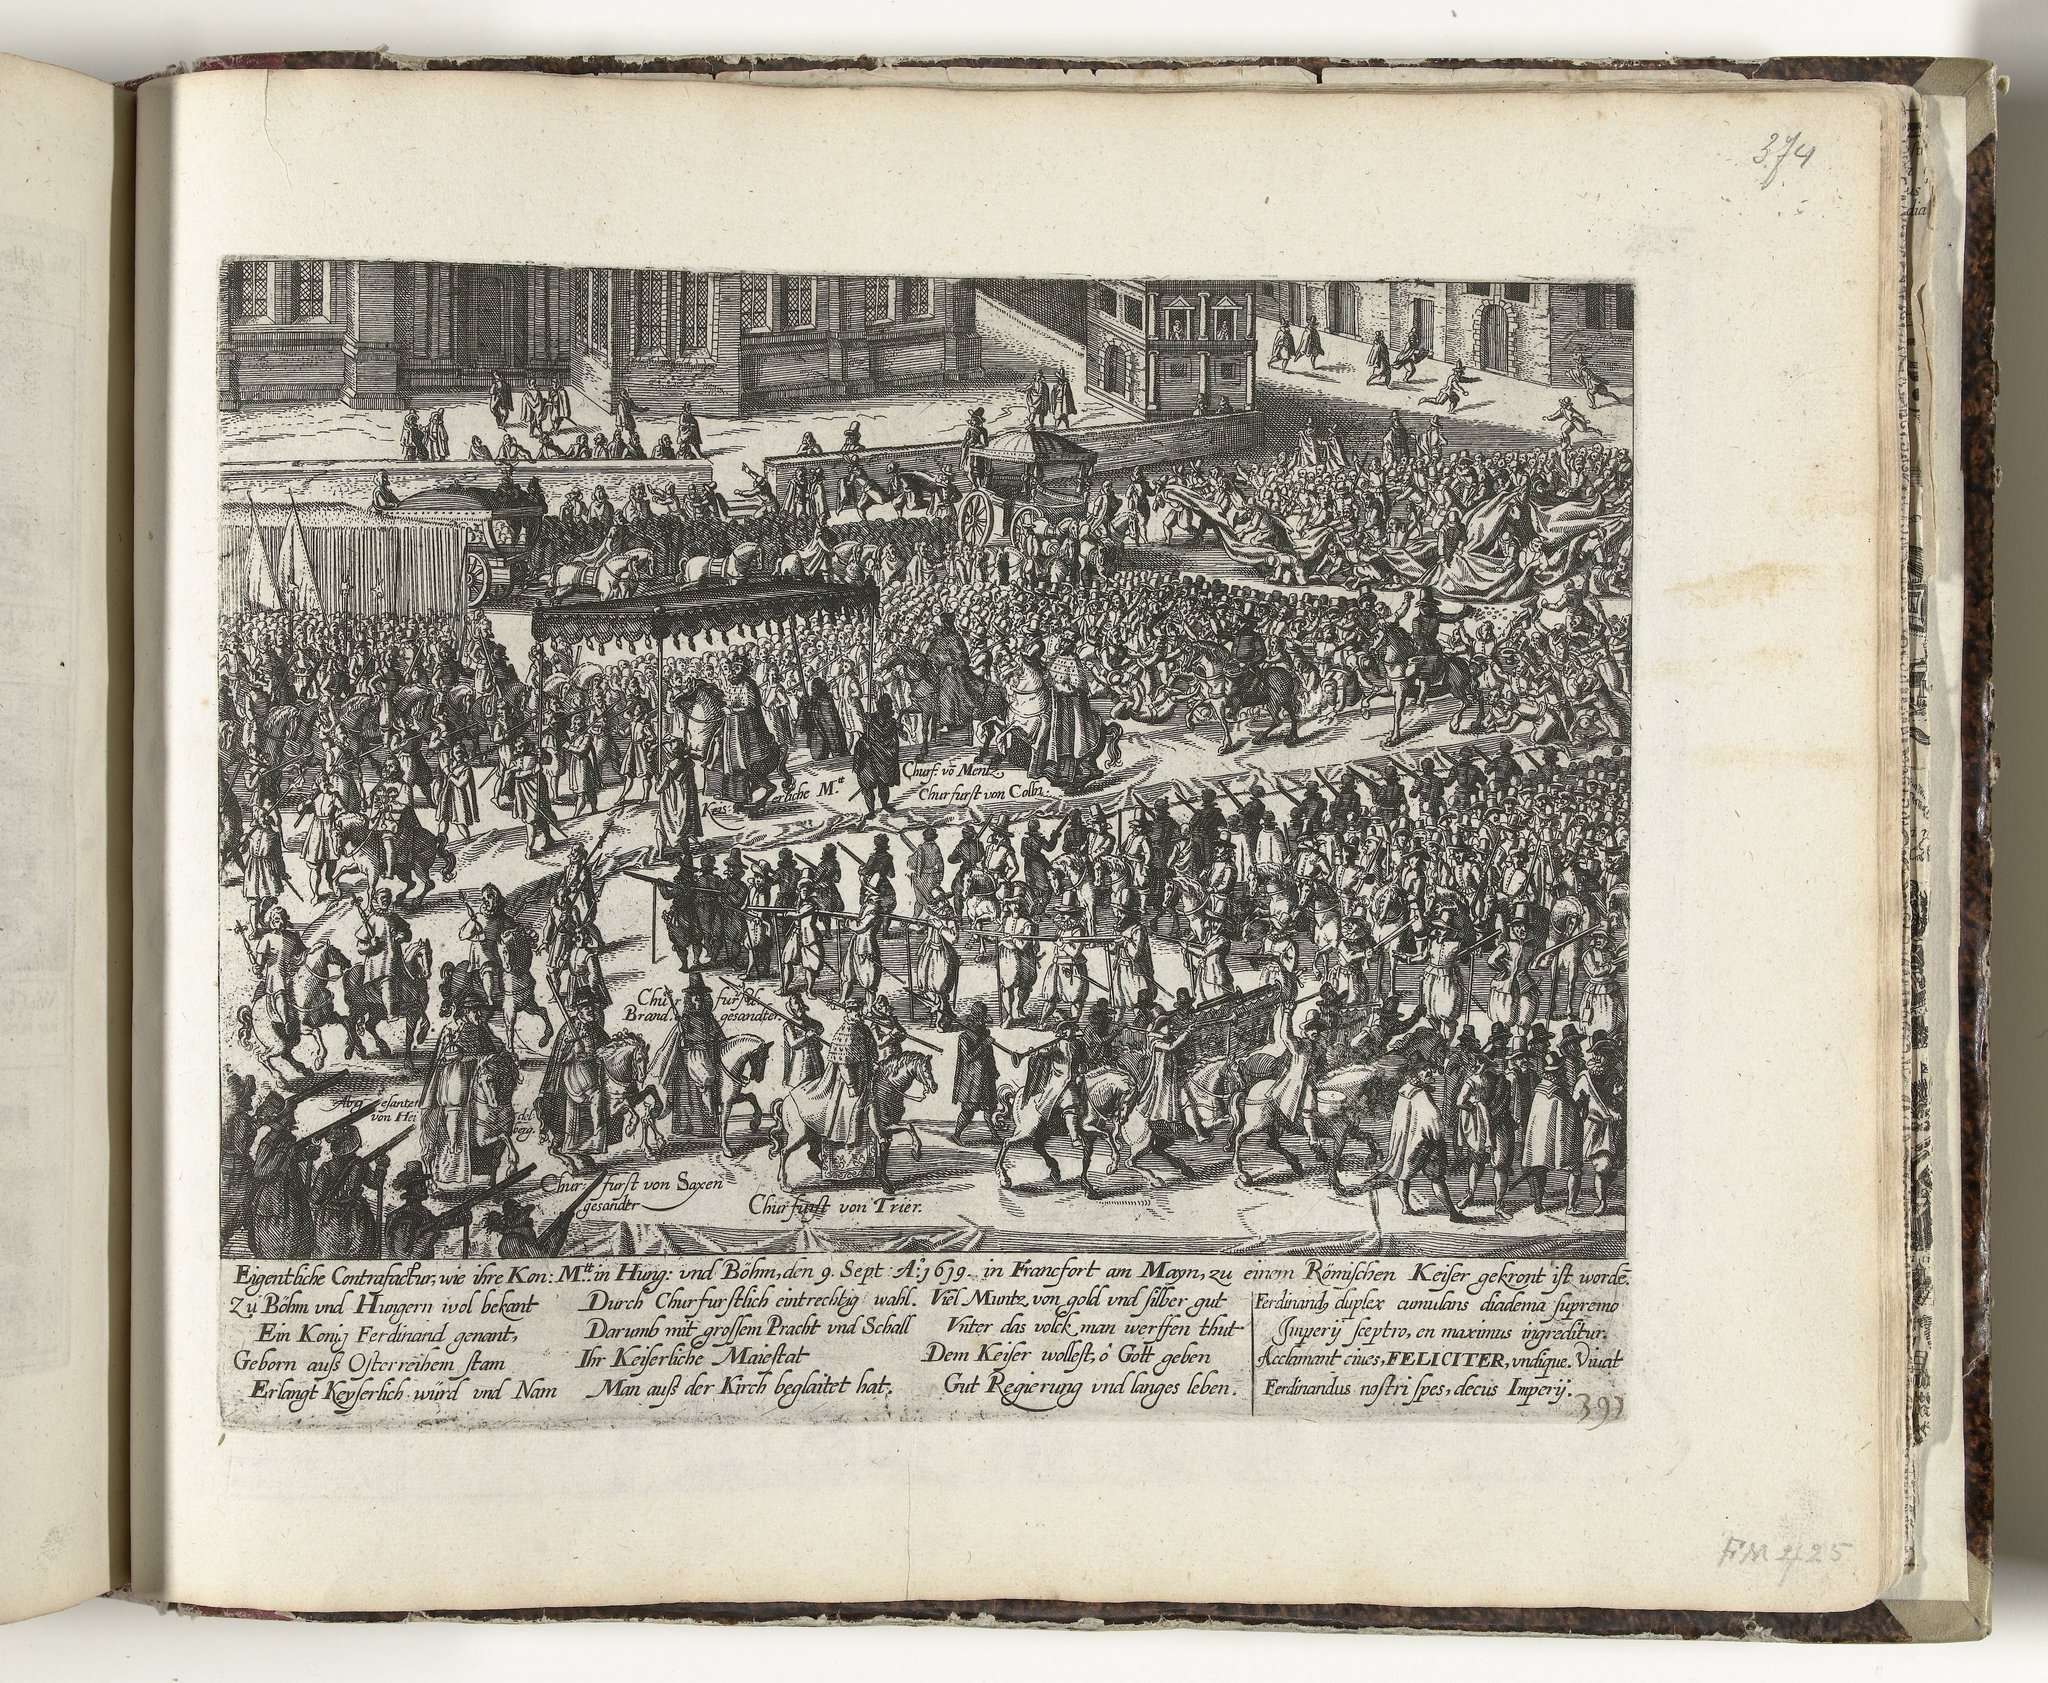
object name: album leaf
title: Optocht na de kroning van Ferdinand II tot Rooms koning, 1619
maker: frans hogenberg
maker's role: print maker, publisher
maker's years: 1538-1590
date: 1619-1621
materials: paper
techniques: etching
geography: cologne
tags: vienna, ferdinand ii (duits keizer), public festivities at other royal events, not meant or mentioned above, after the coronation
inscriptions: inscription: ‘397’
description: Feestelijke optocht te Frankfurt am Main na de kroning van Ferdinand II tot Rooms koning, 9 september 1619. Met onderschrift van 12 regels in het Duits en 4 regels in het Latijn. Rechtsonder met pen genummerd: 397. De prent maakt deel uit van een album.